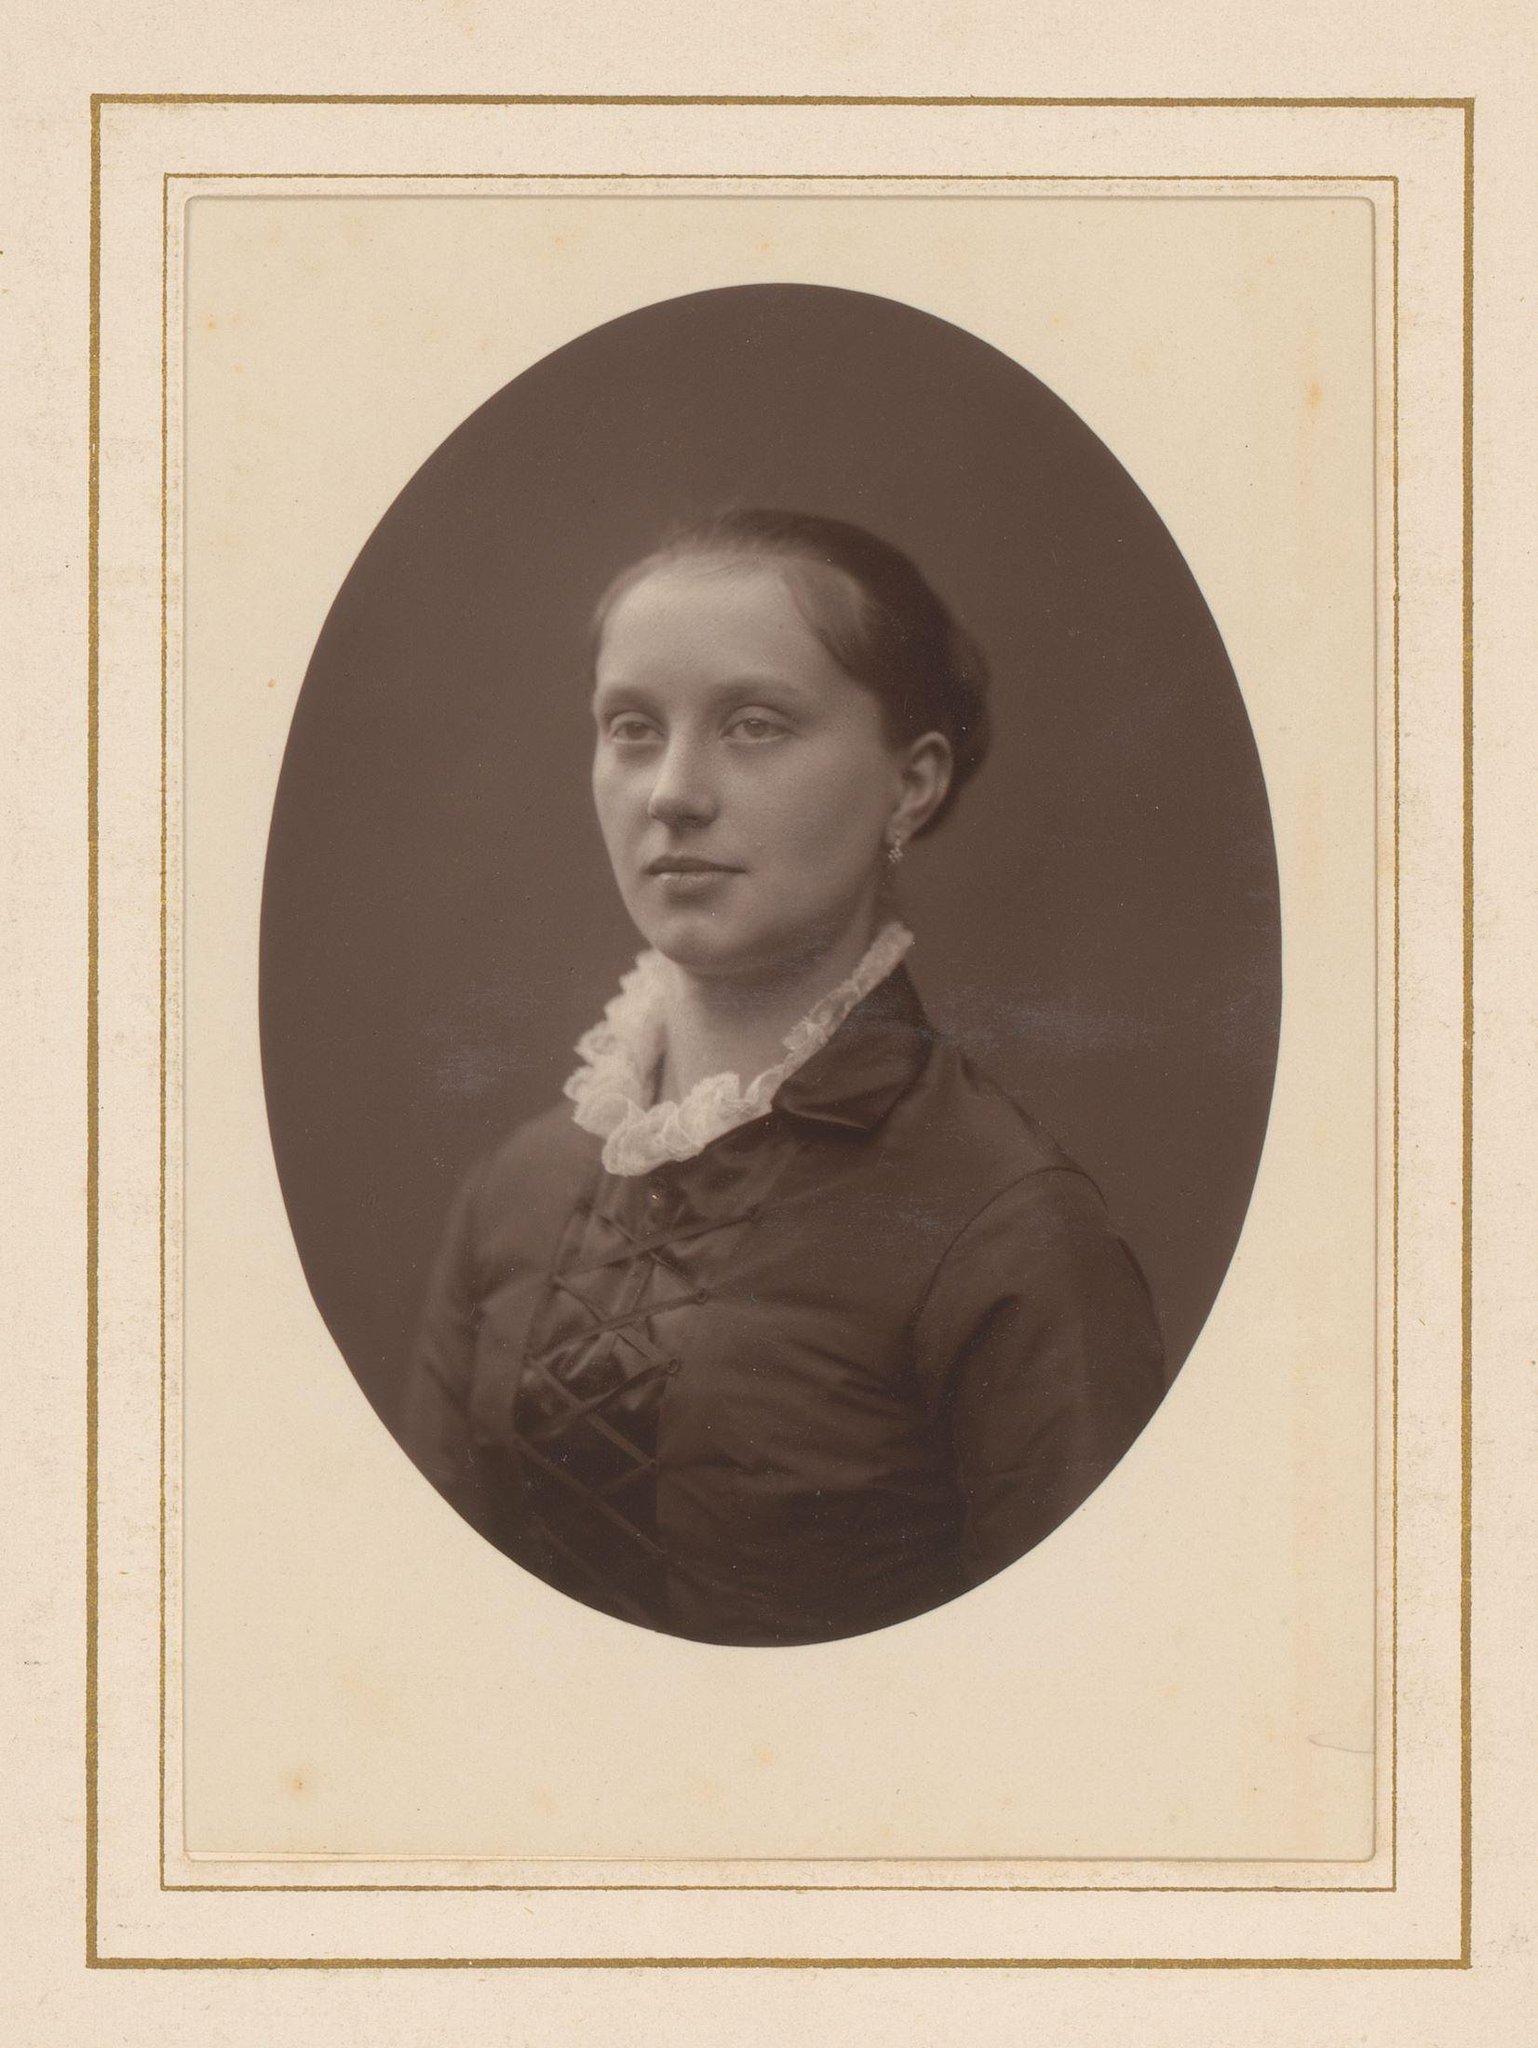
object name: album leaf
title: Portret van een vrouw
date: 1878-1890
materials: cardboard, paper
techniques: carbon print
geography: brussels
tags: historical persons - bb - woman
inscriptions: inscription: ‘PROCÉDÉ INALTÉRABLE/ Photographie au Charbon/ (...)/ Géruzet Frères/ Photographes de S.M. la Reine des Belges/ 27b. Rue de l'Ecuyer/ Bruxelles/ Les Clichés sont conservés’, annotation: ‘a la famille Berlier/ Reconnaissance/ Mr Hense[r]al F[in]et’